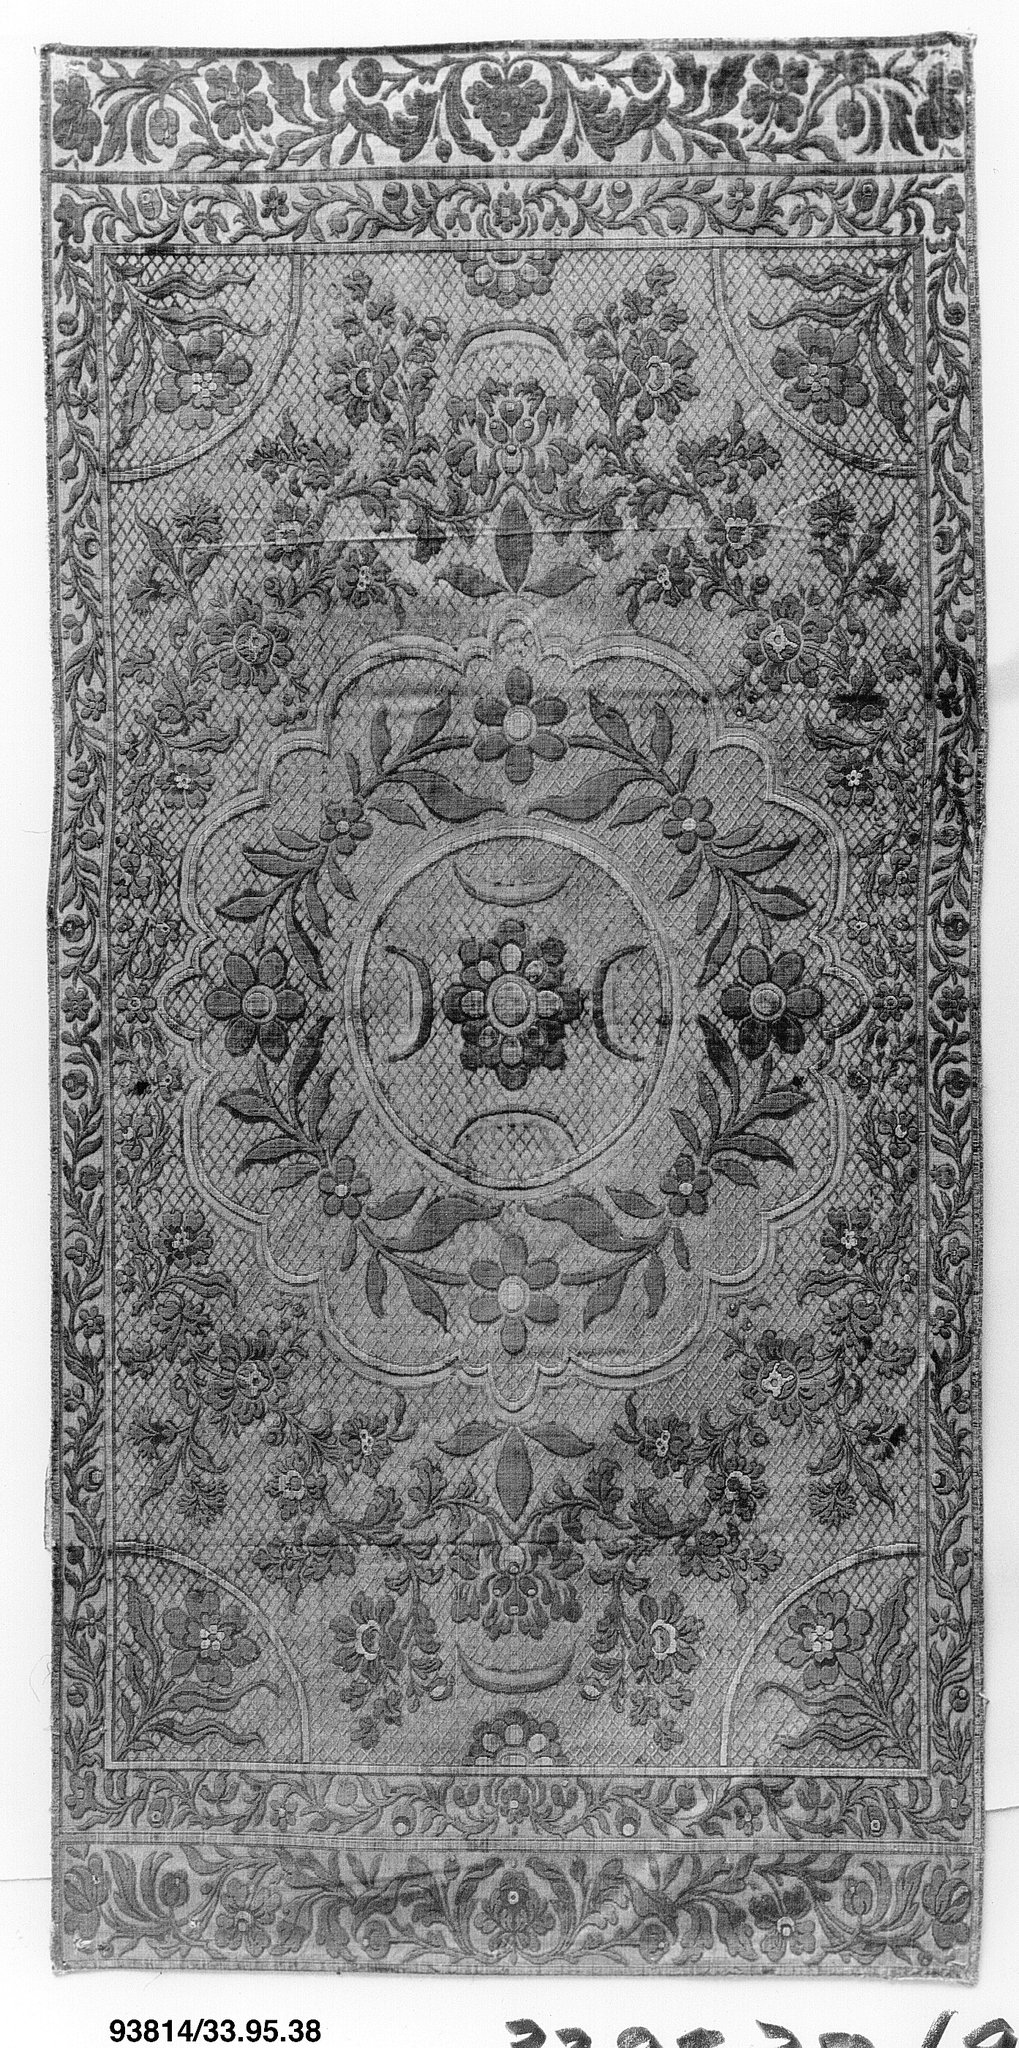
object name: panel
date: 1701-1900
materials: metal thread, silk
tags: flowers